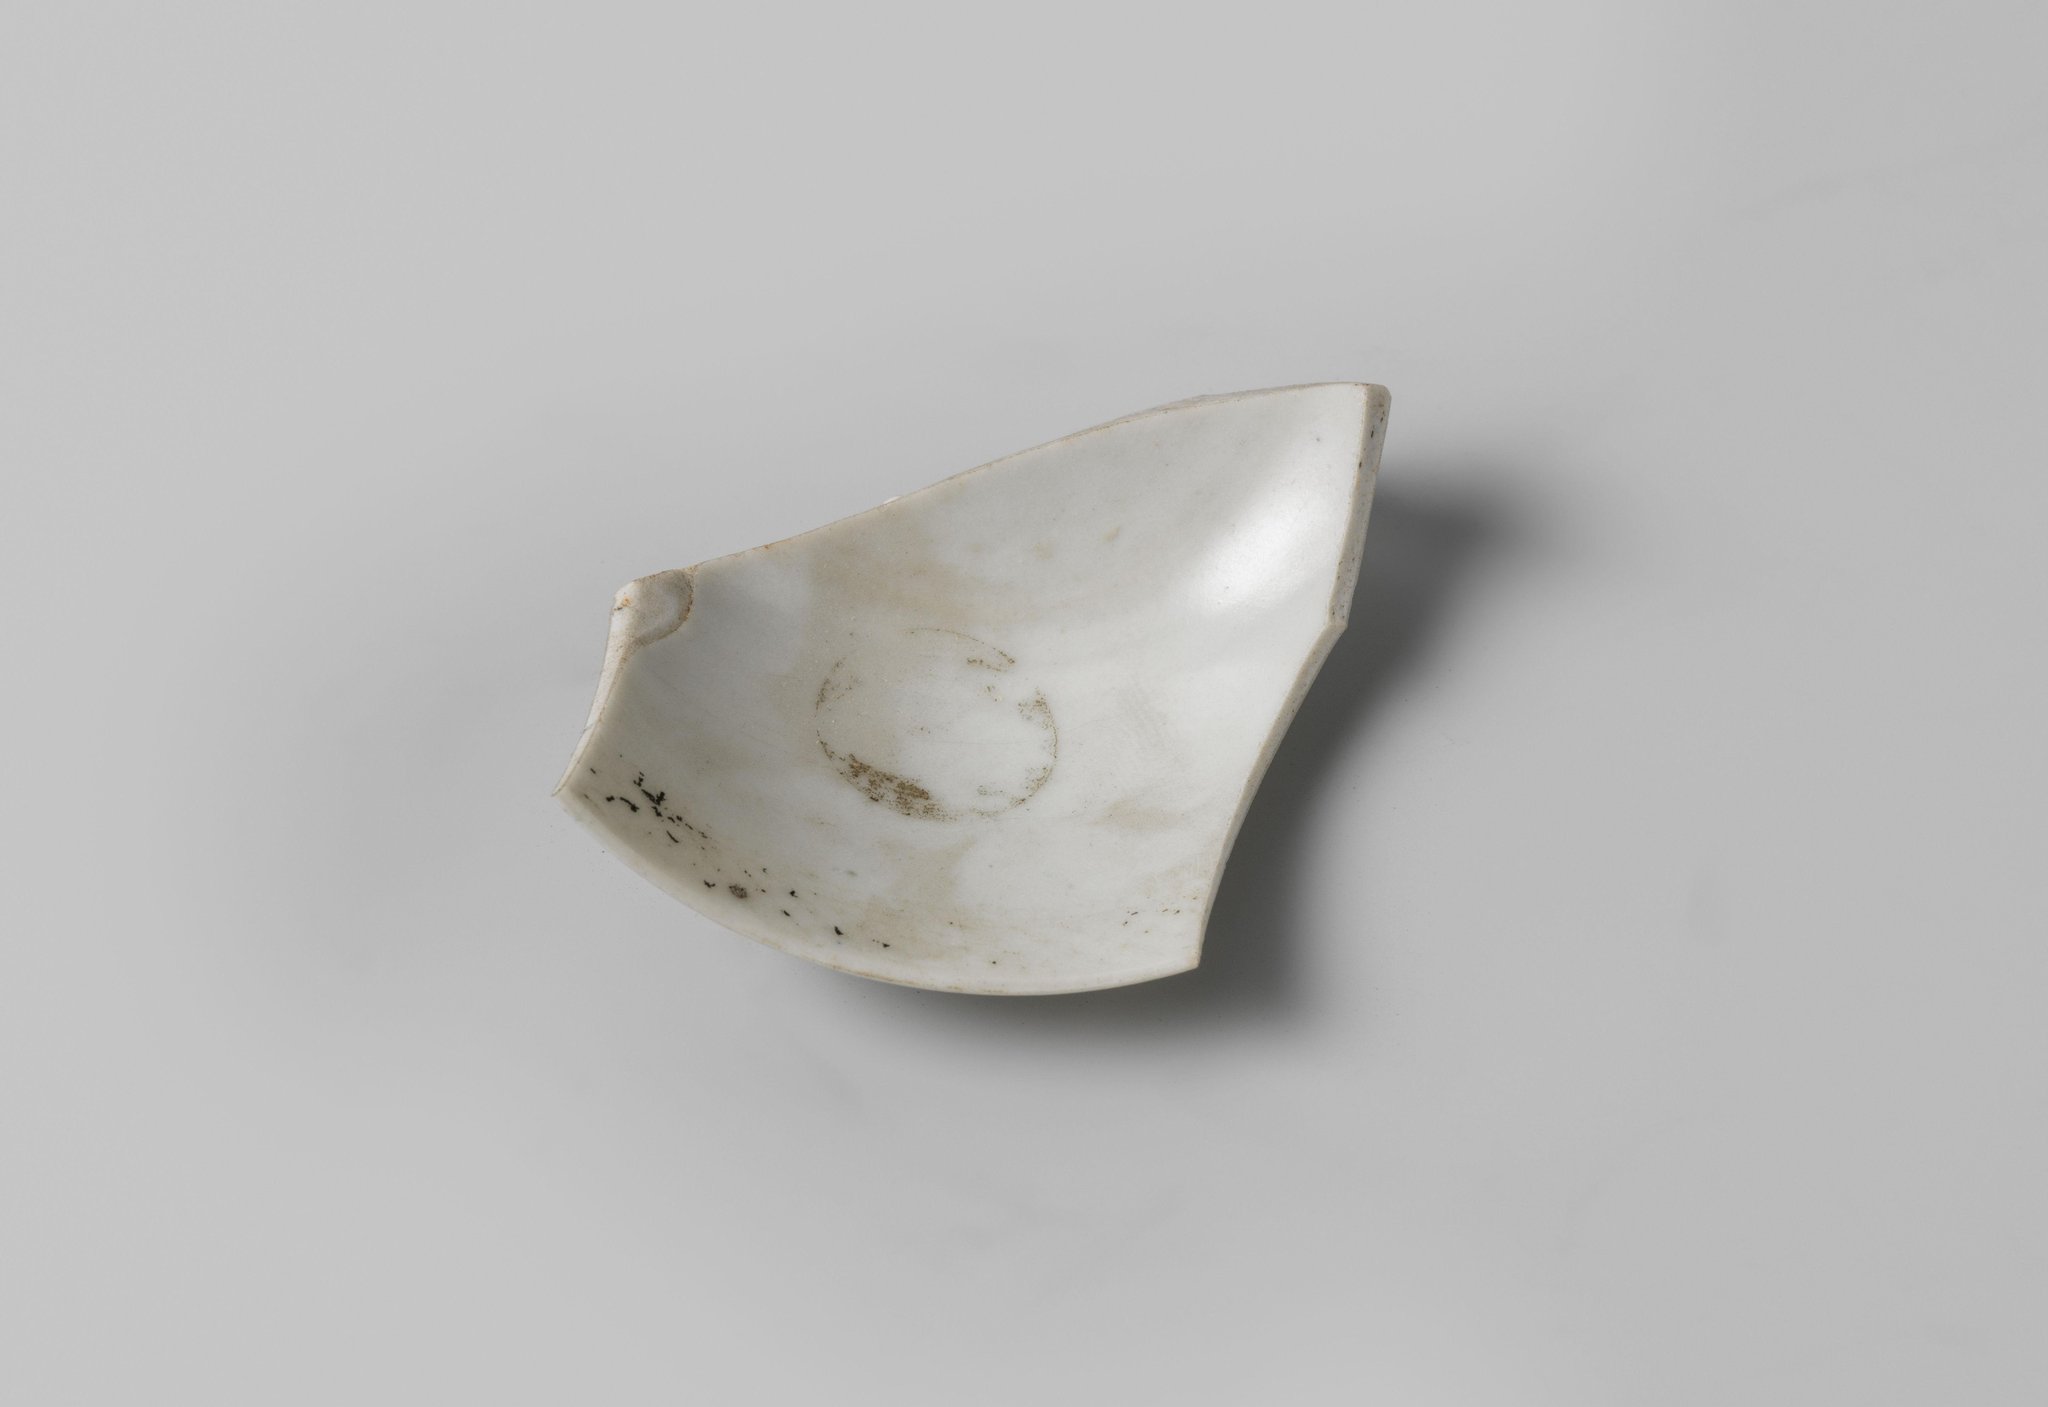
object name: cup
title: Kop, gevonden bij V.O.C.-schip Witte Leeuw, mogelijk afkomstig van Zeelelie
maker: Anonymous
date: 1775-1800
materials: porcelain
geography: jingdezhen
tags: verenigde oostindische compagnie, sint-helena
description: Scherf van een kop gemaakt voor export naar Anglo-Saxische landen, Nanking-ceramiek bord. Dit object is 18e-eeuws en kan dus niet van de vracht van de Witte Leeuw zijn. Onduidelijk is of het object van de site komt of dat het later is vermengd, mogelijk met materiaal van de Zeelelie.